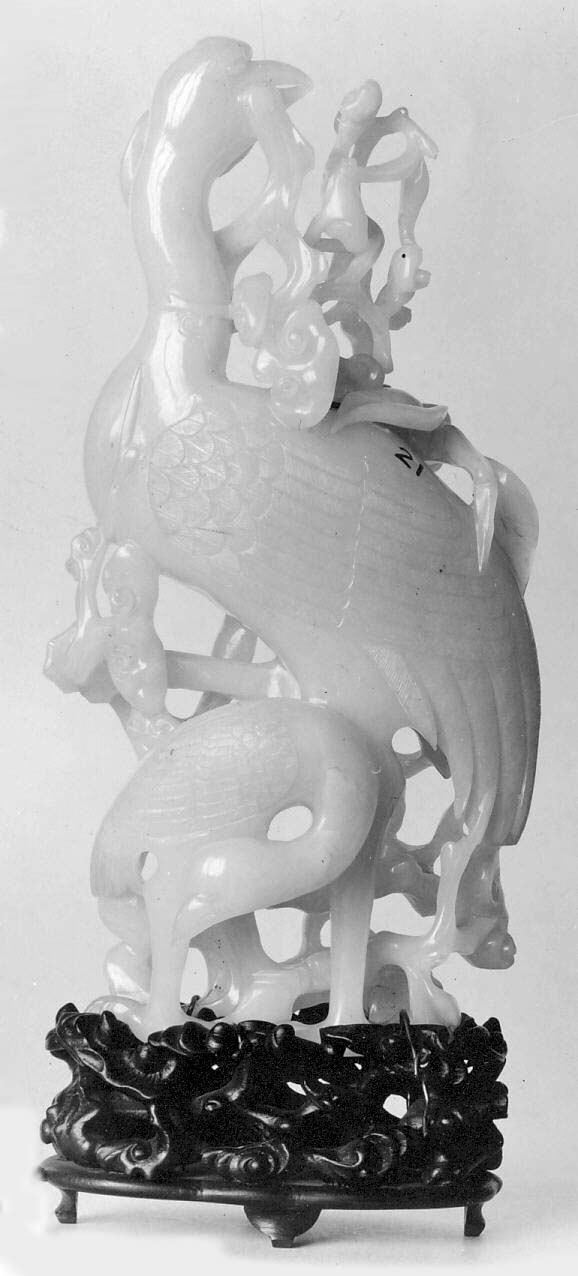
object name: covered vase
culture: chinese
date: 1736-1795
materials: jade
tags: phoenix